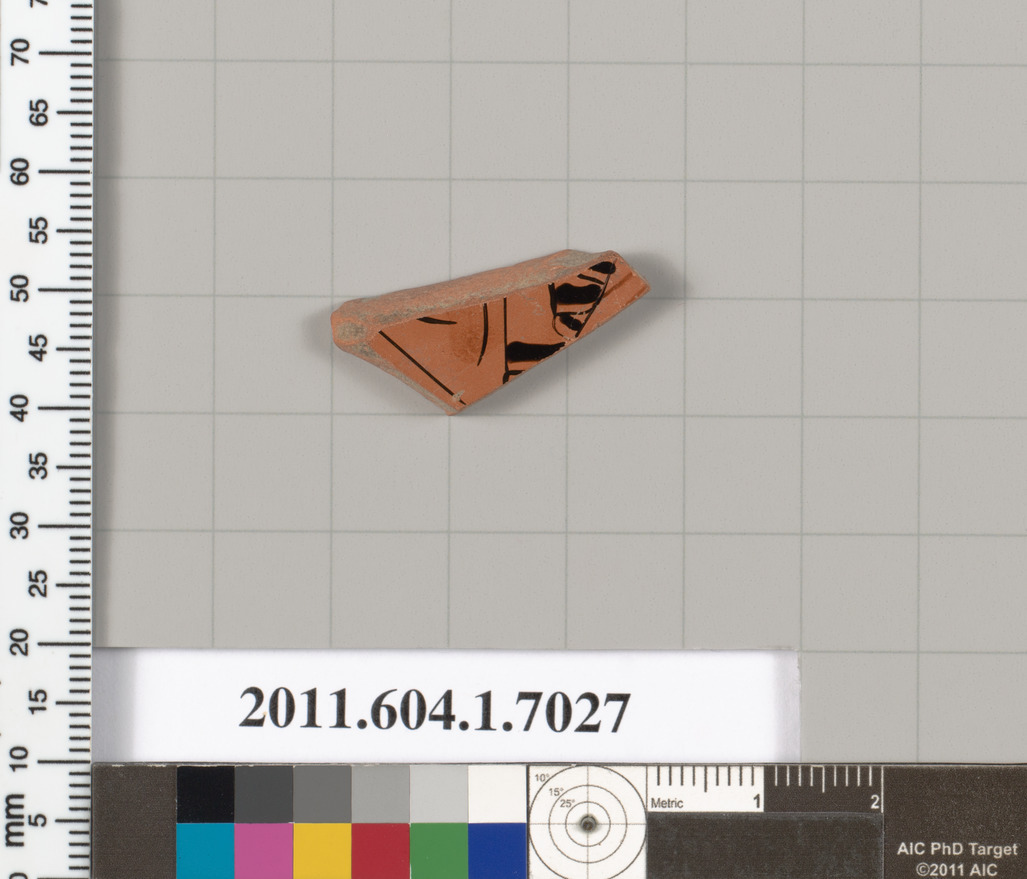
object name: kylix fragment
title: Terracotta fragment of a kylix (drinking cup)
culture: greek, attic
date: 500-490 BCE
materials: terracotta